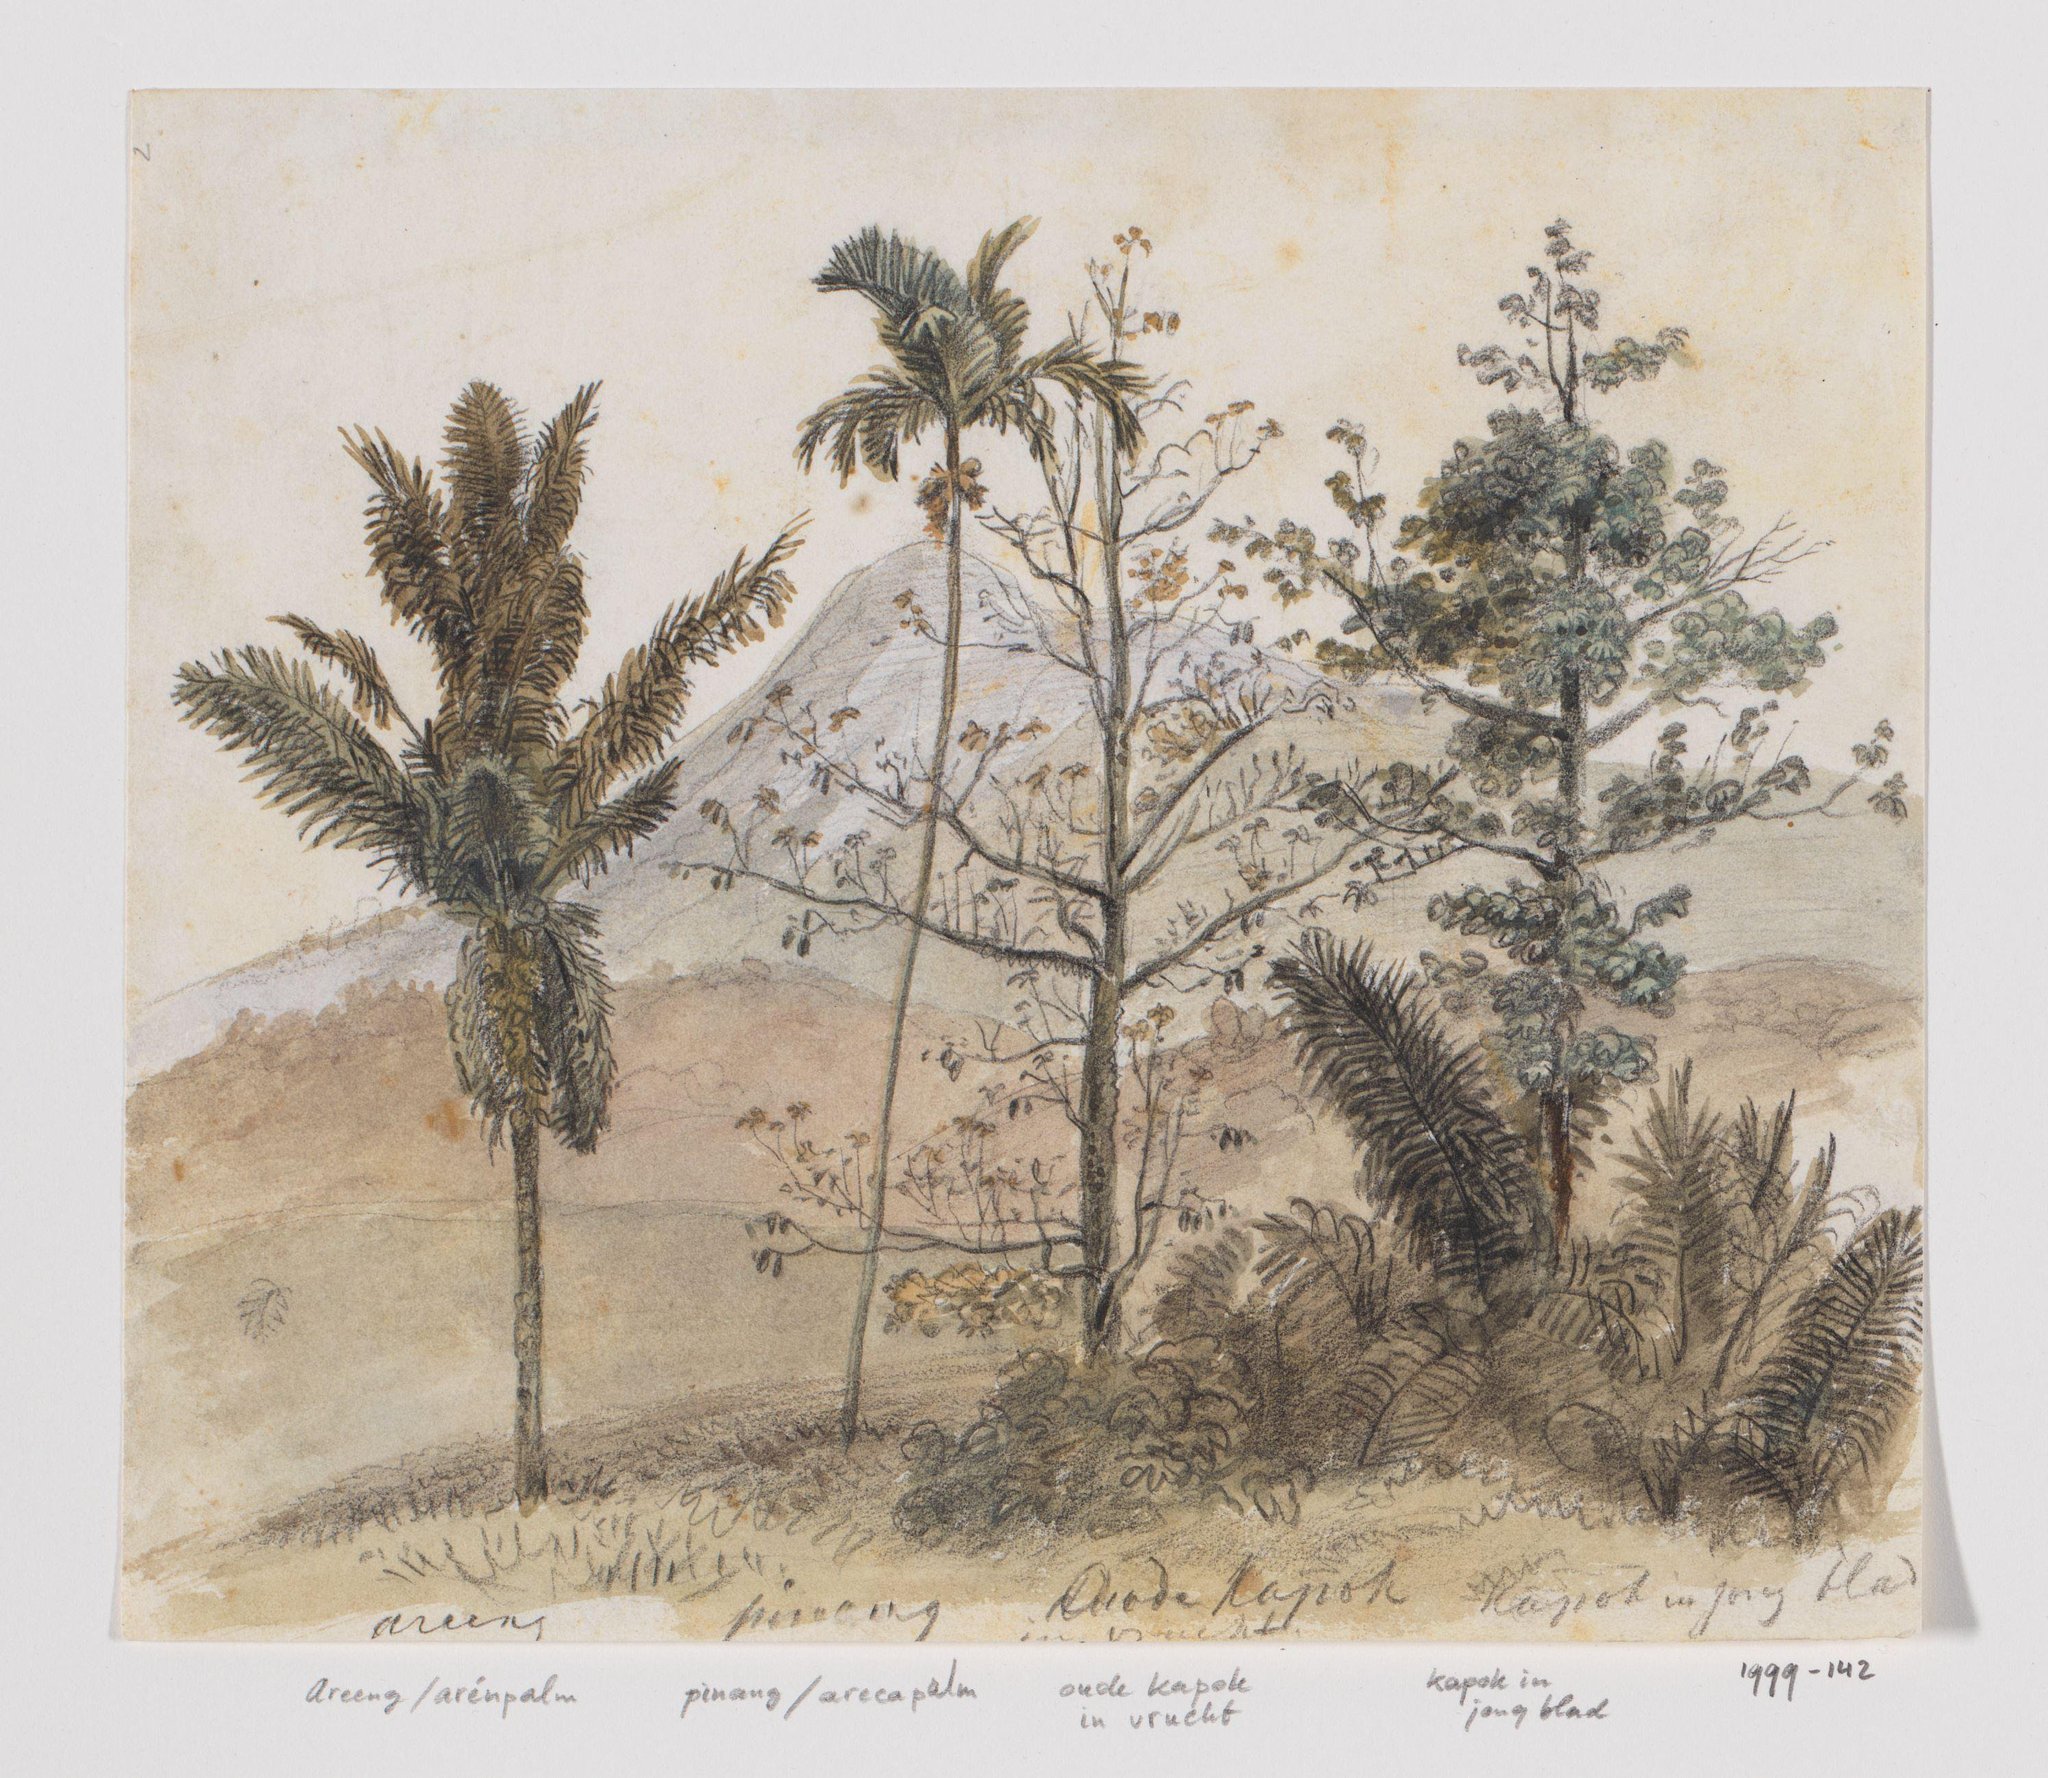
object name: topographical view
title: Bomen in berglandschap Java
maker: adrianus johannes bik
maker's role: draughtsman, print maker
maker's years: 1790-1872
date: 1816-1846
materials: chalk, paper, pencil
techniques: brush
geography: java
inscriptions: annotation: ‘areeng/ pinang/ oude kapok in vrucht/ kapok in jong blad’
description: artikel over deze collectie in Bulletin van het Rijksmuseum 49 [2001], nr. 4, pp.343 e.v.